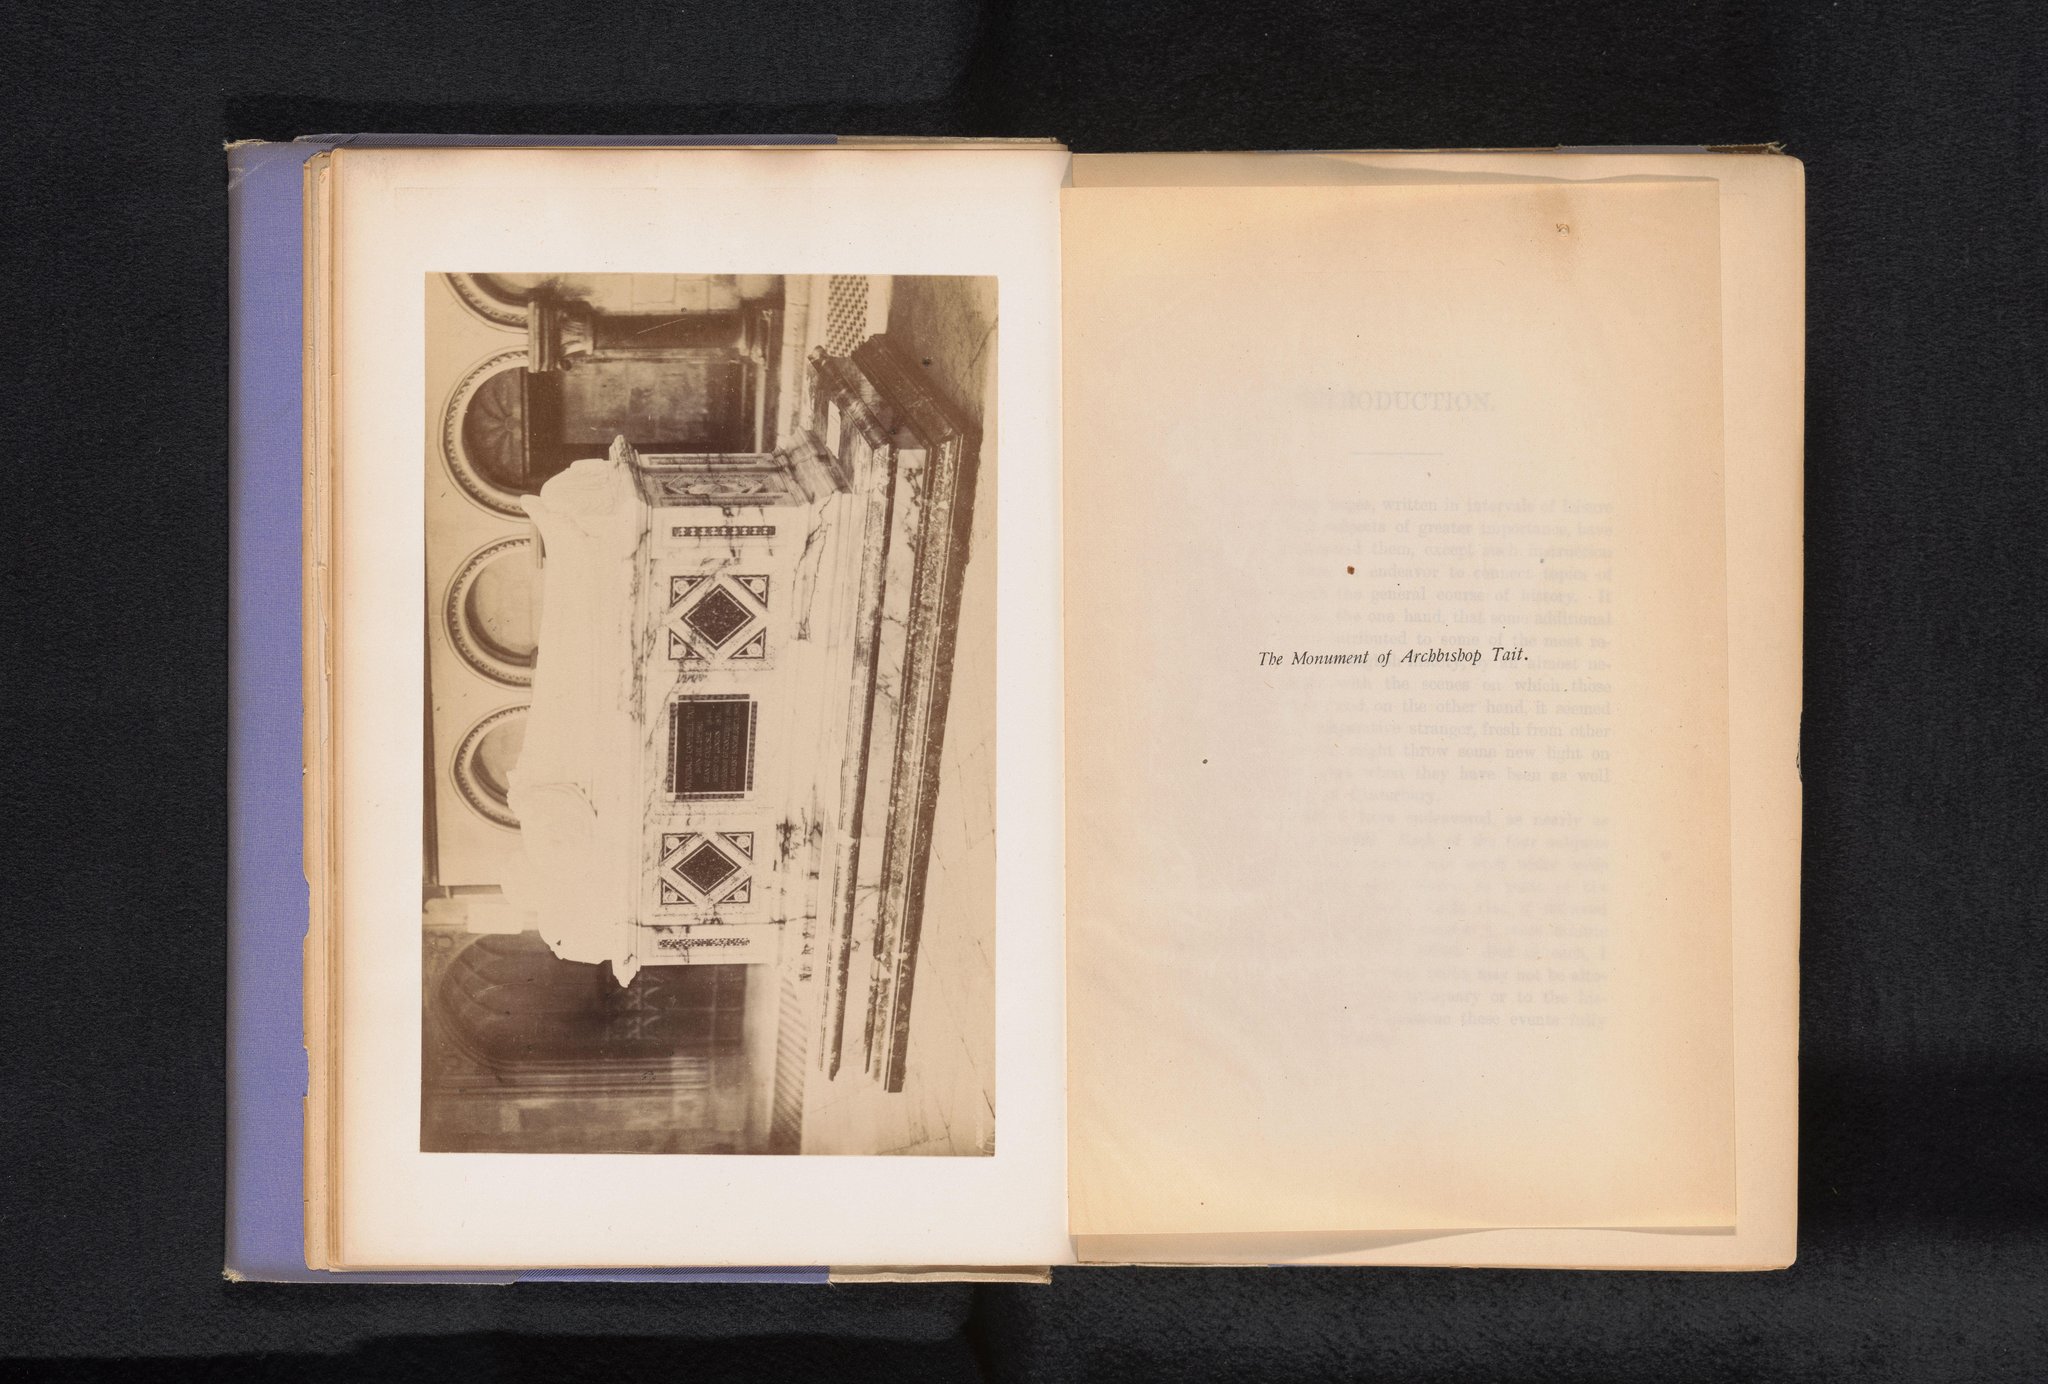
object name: photograph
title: Tombe van Archibald Campbell Tait in de kathedraal van Canterbury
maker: Anonymous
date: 1882-1892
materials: photographic support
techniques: albumen print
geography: canterbury cathedral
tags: grave, tomb